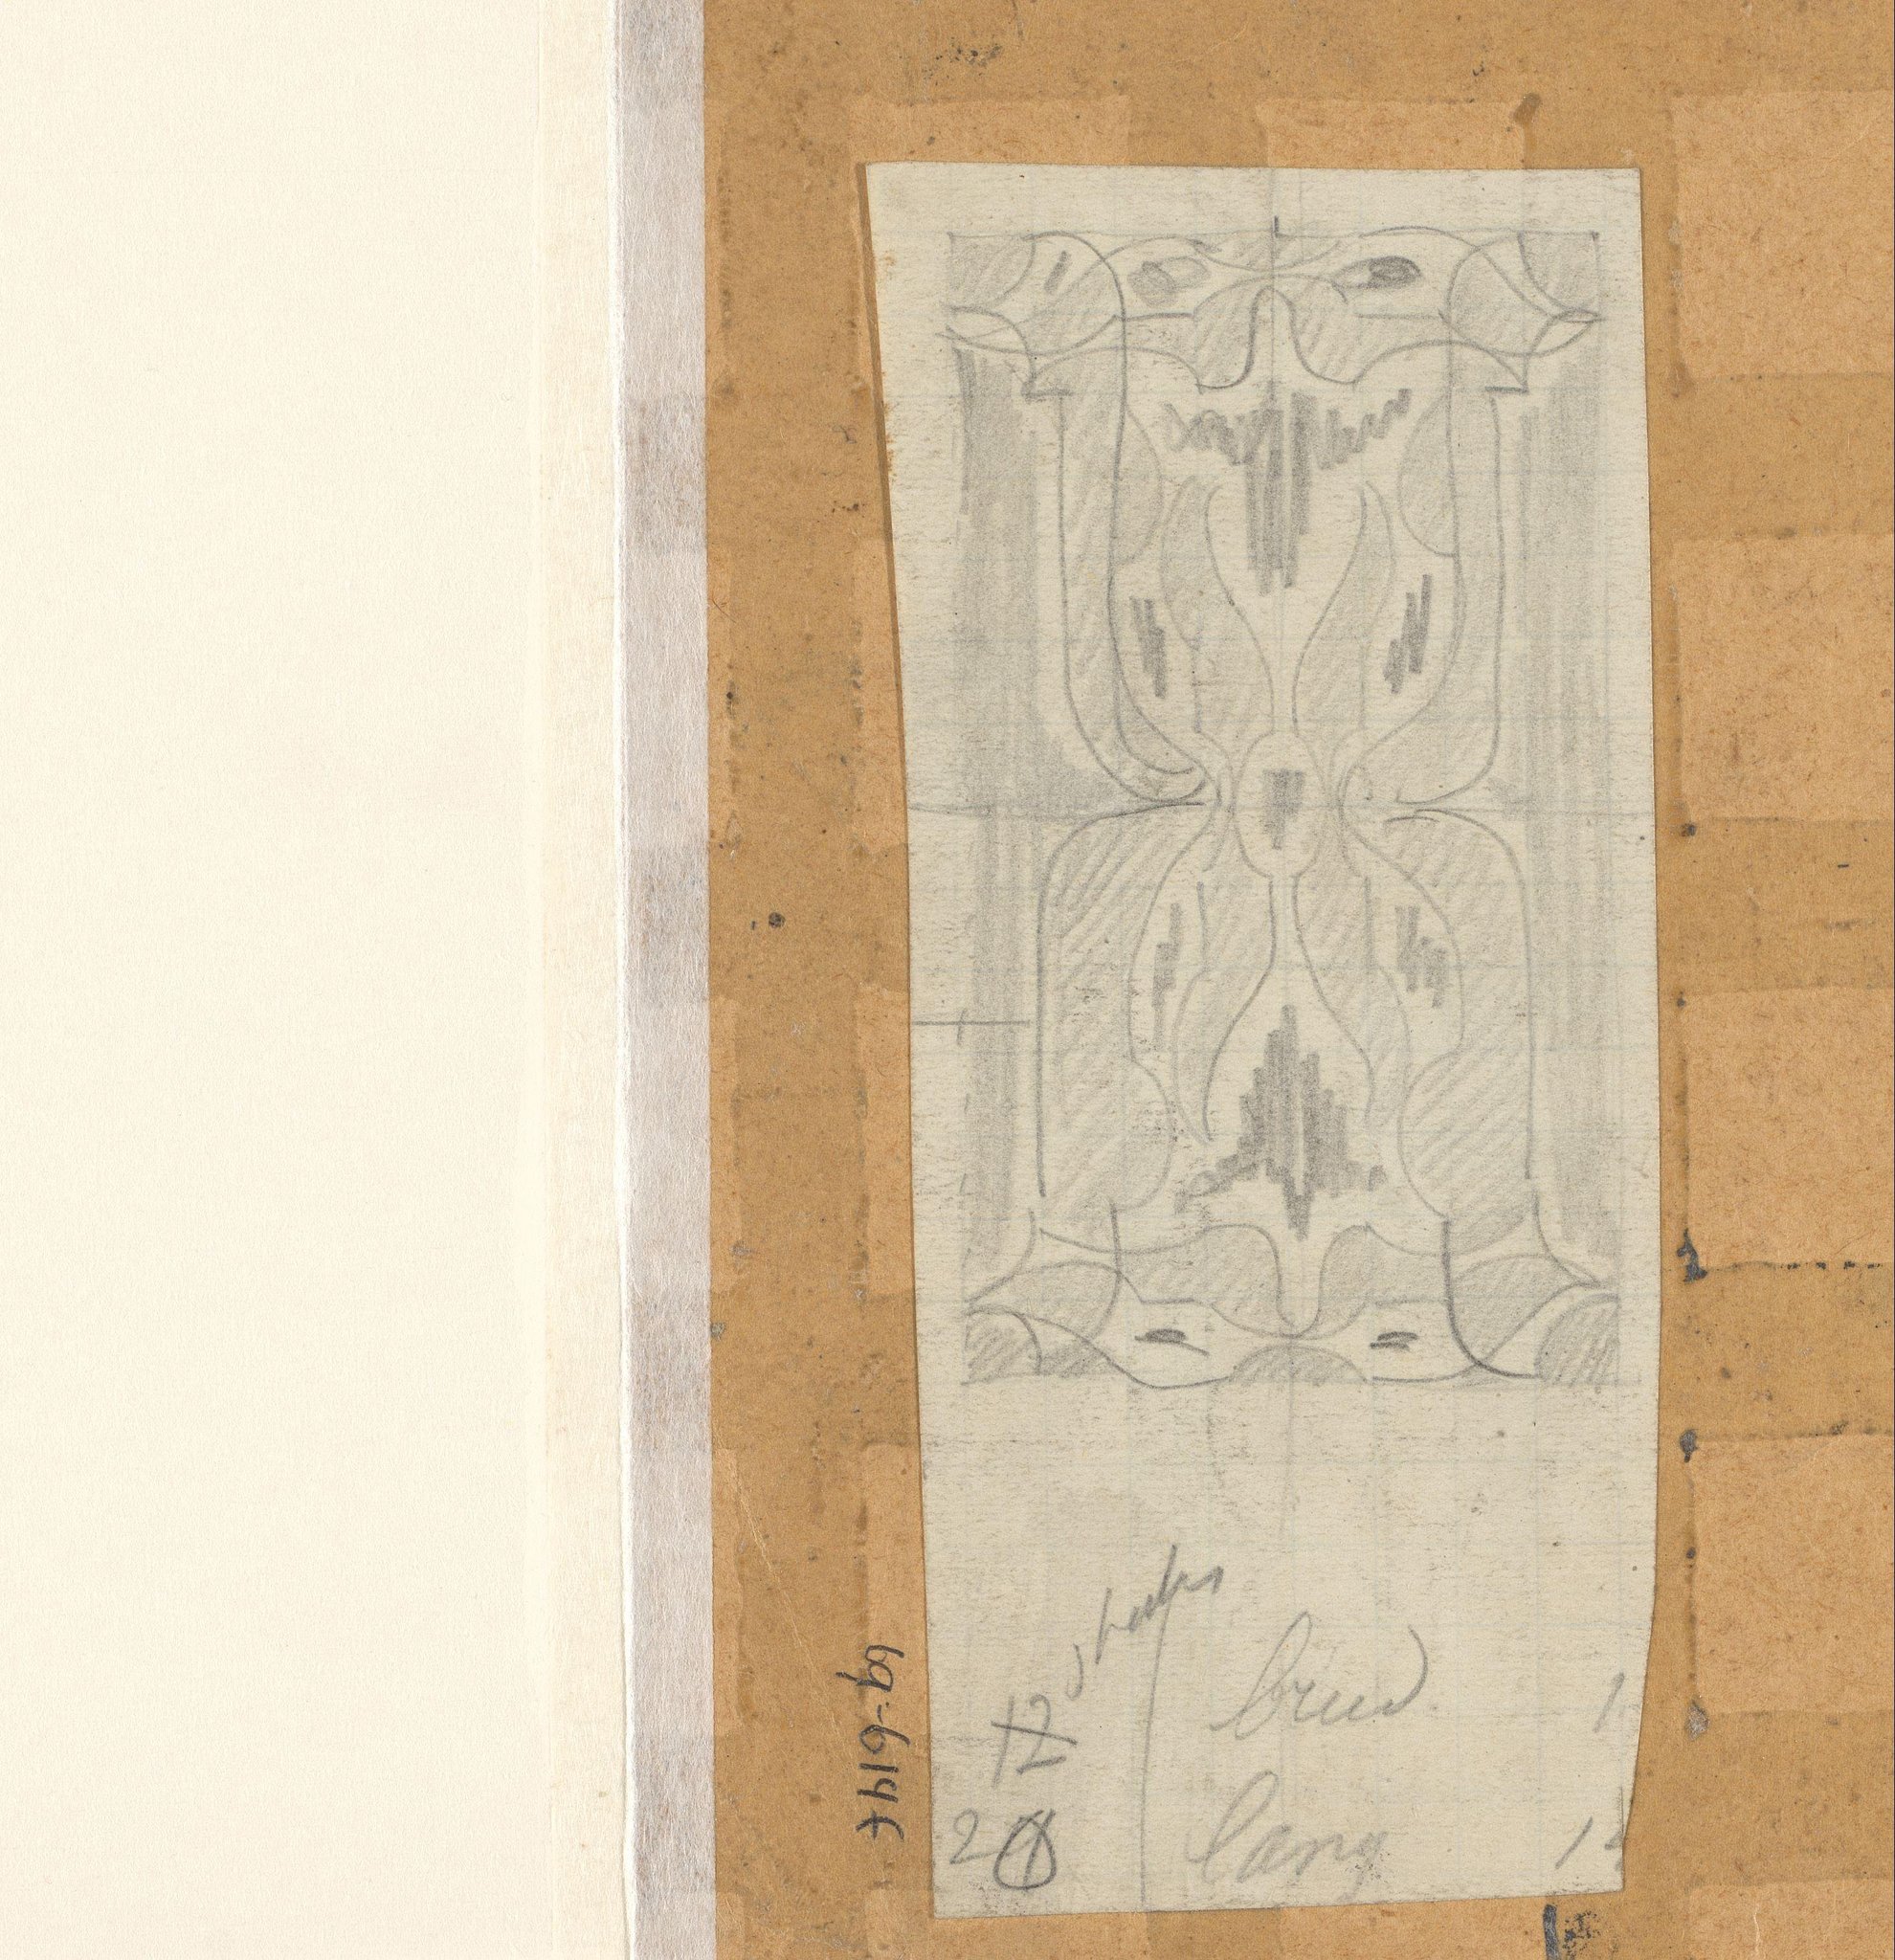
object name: drawing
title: Decoratief ontwerp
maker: carel adolph lion cachet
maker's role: draughtsman, print maker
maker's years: 1864-1945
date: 1874-1945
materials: pencil